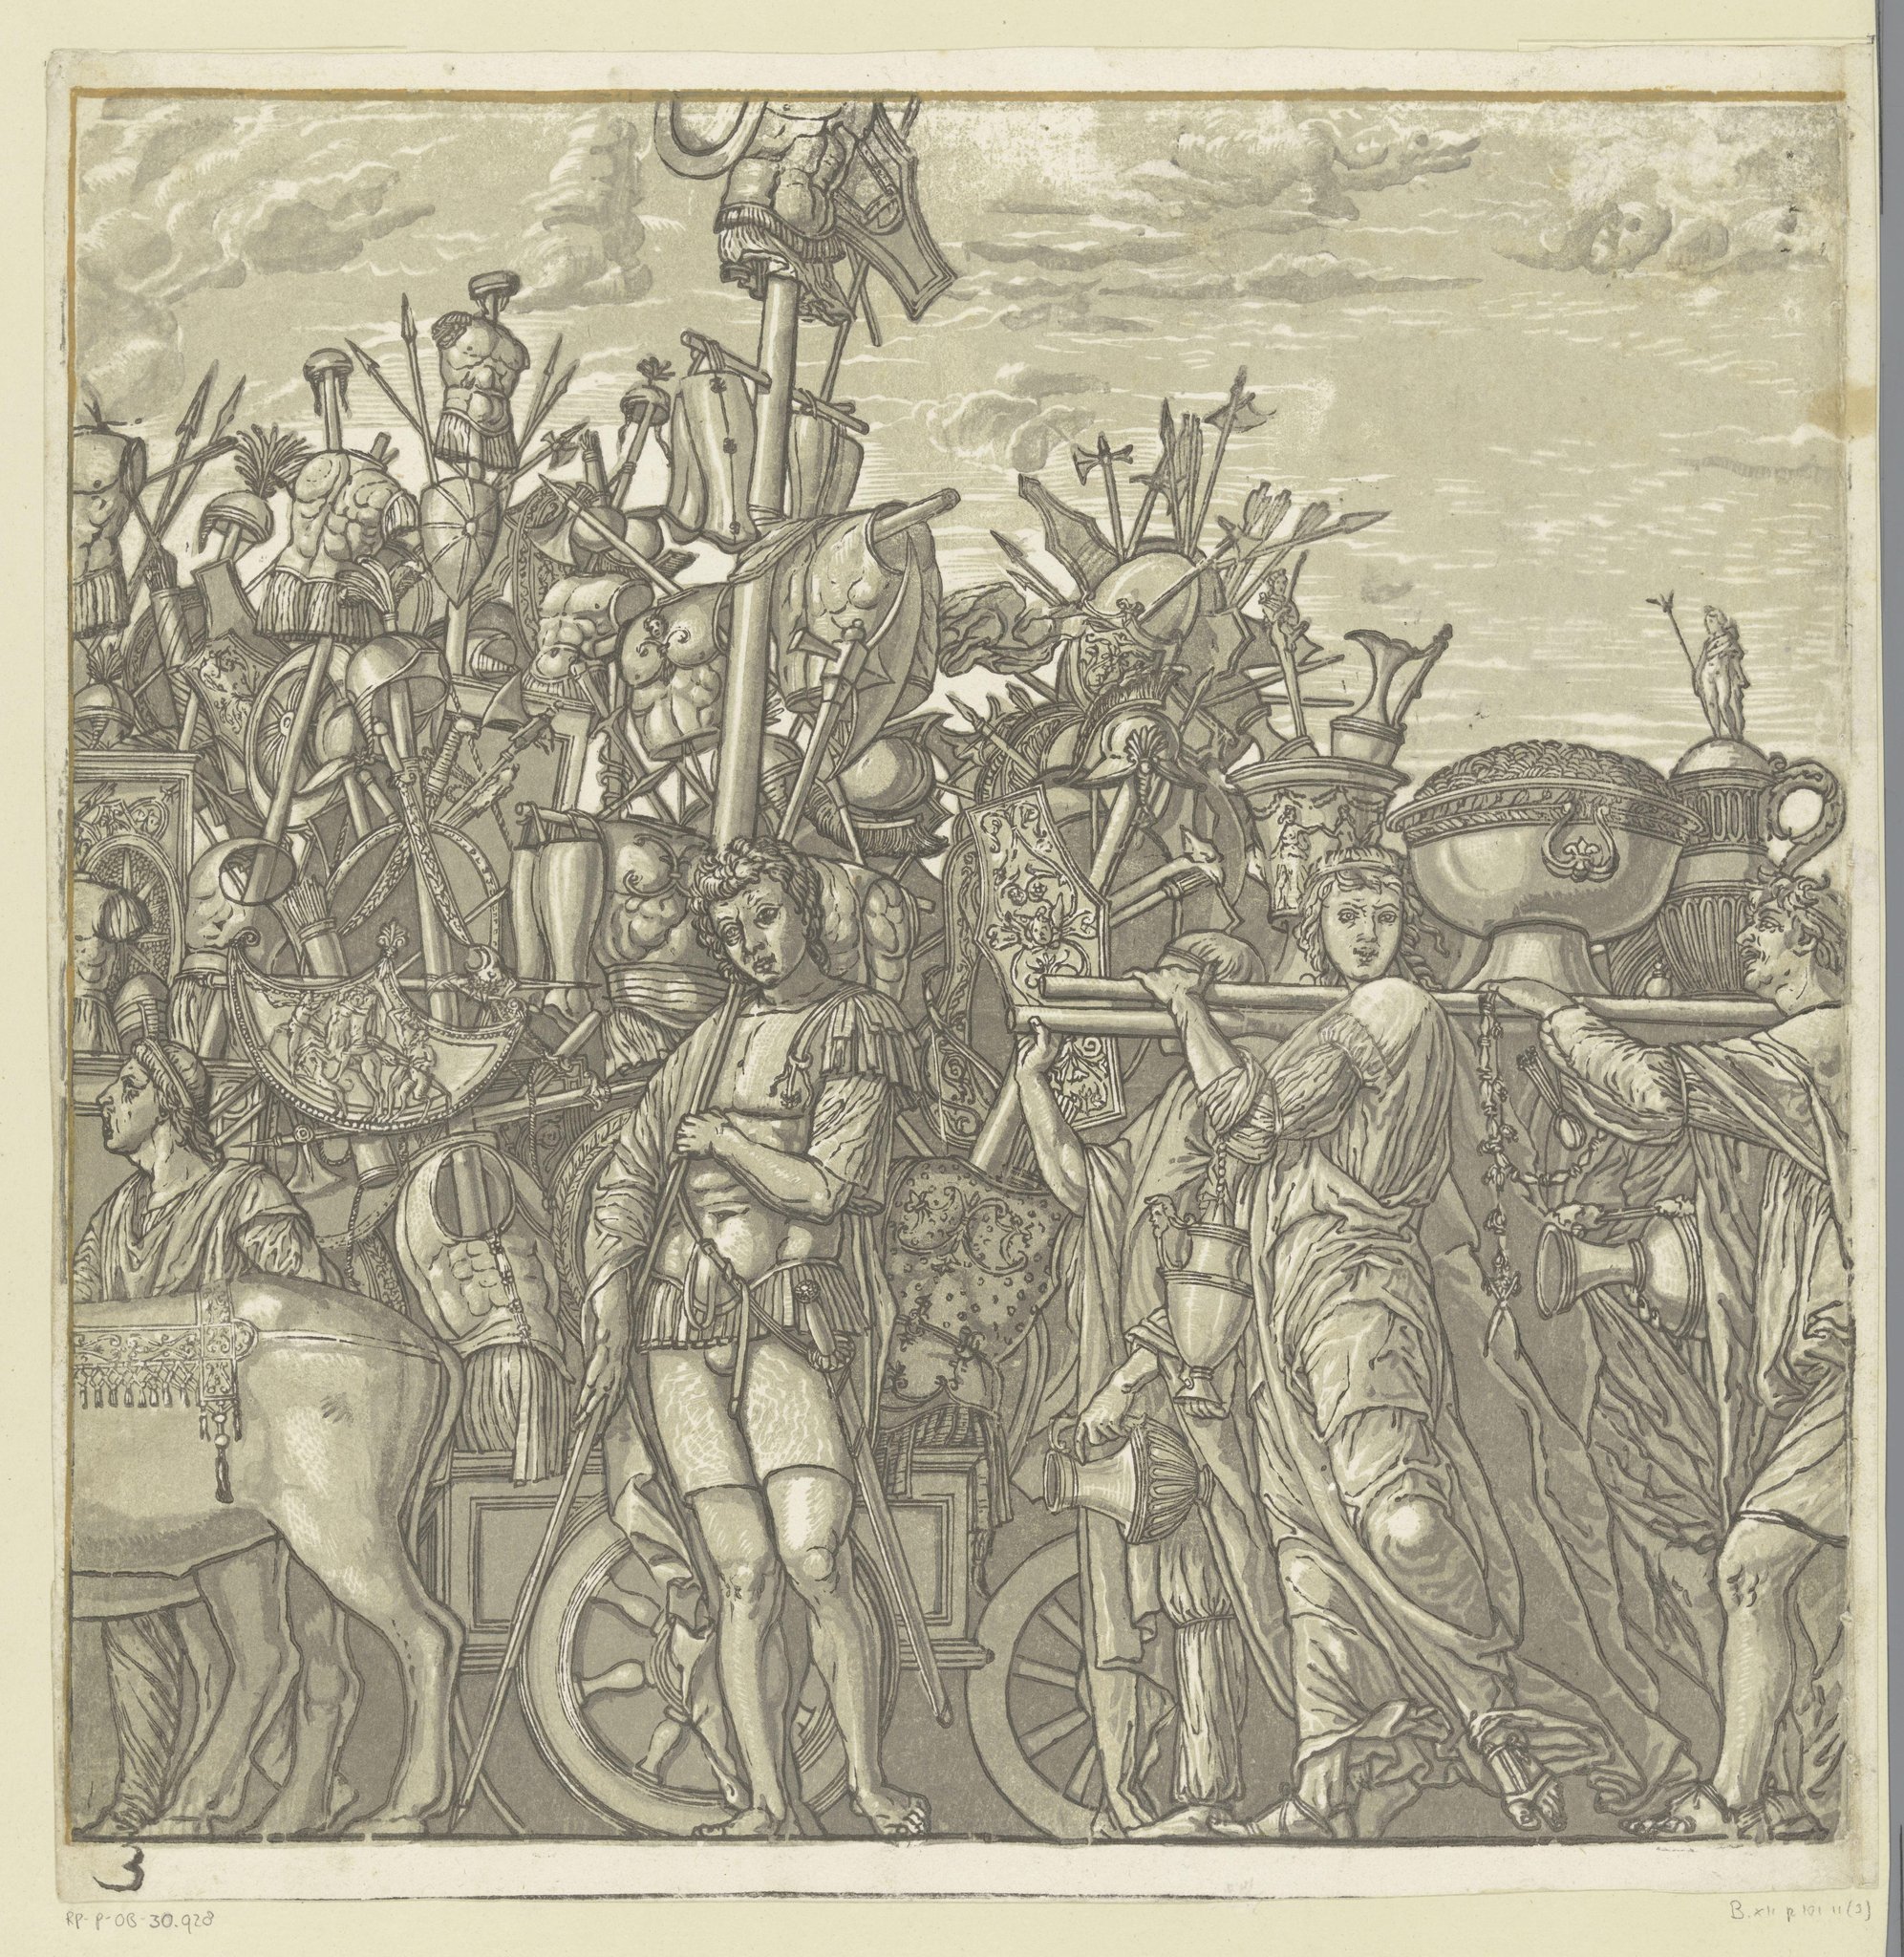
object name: print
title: Triomftocht van Julius Caesar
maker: andrea andreani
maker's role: print maker, printer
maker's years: 1558-1629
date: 1599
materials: paper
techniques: woodcut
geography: italy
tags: armour, triumph of caesar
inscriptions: collector's mark: Lugt 240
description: Deze prent maakt deel uit van een fries dat bestaat uit een titelprent en negen prenten die samen een triomftocht van Julius Caesar vormen. Bij de serie hoort tevens een prent met daarop zes Korinthische pilasters, bedoeld om te worden uitgeknipt en gebruikt als verbindingsstukken tussen de verschillende bladen.